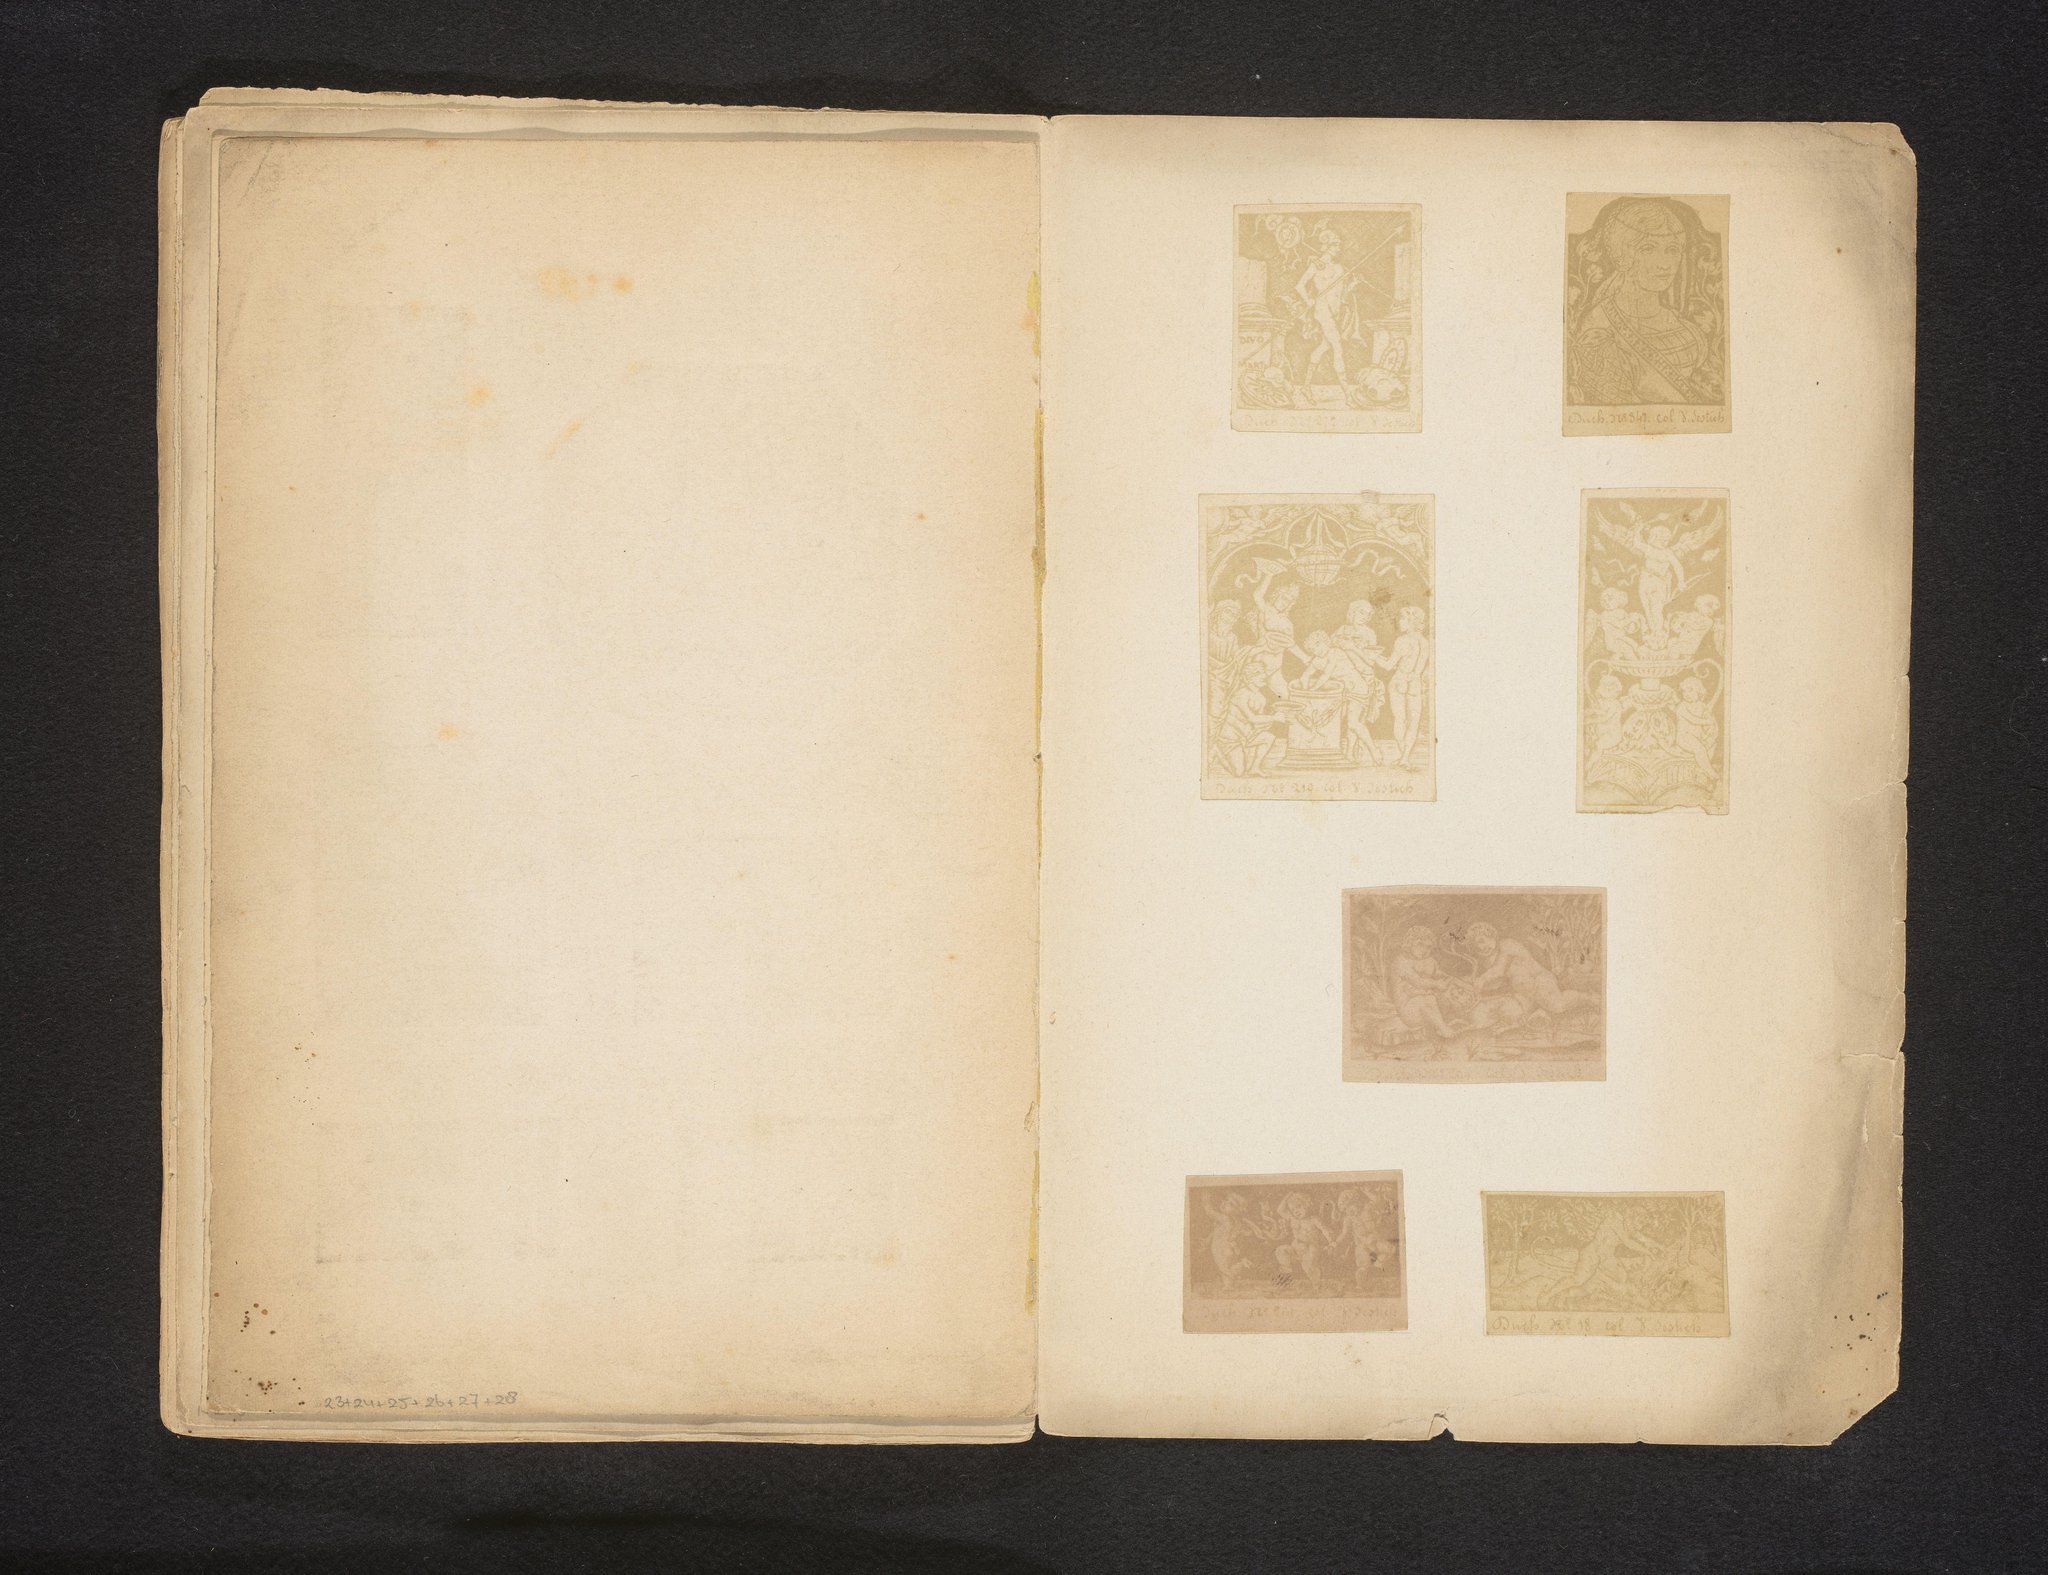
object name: reproduction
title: Fotoreproductie van een prent van de triomf van de liefde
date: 1852-1857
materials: photographic support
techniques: salted paper print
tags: vase ~ ornament, cupids: 'amores', 'amoretti', 'putti'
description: Foto op blad met zeven foto's op negende ongenummerde pagina na pagina 60.